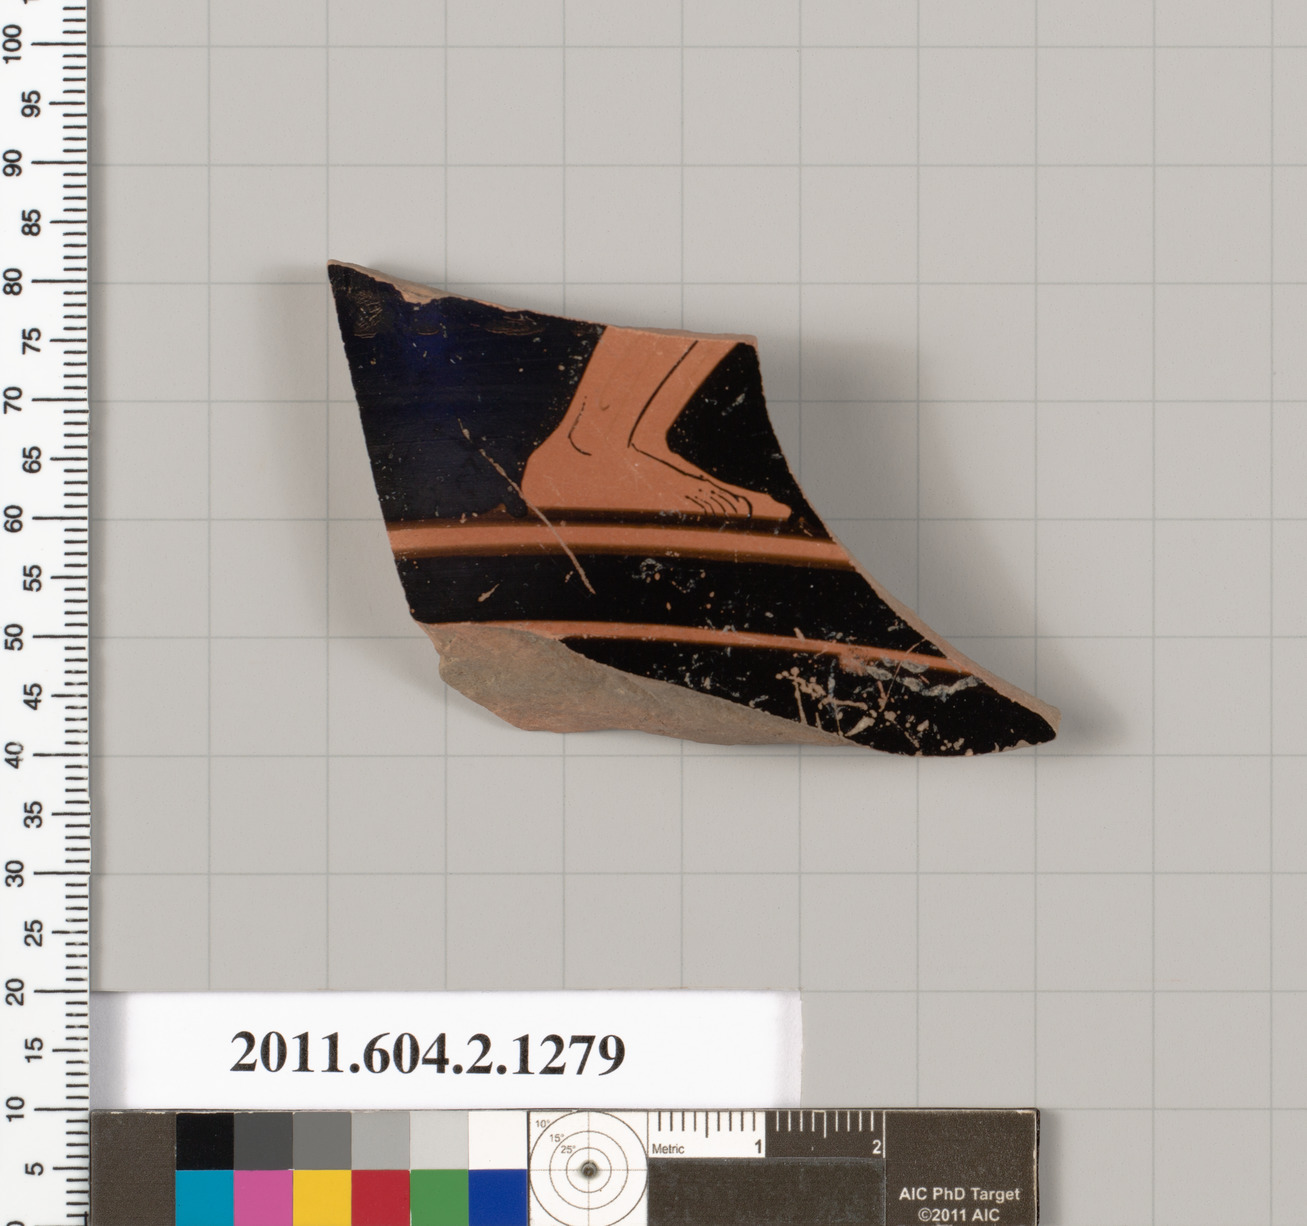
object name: skyphos fragment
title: Terracotta fragment of a skyphos (deep drinking cup)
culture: greek, attic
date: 475-451 BCE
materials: terracotta